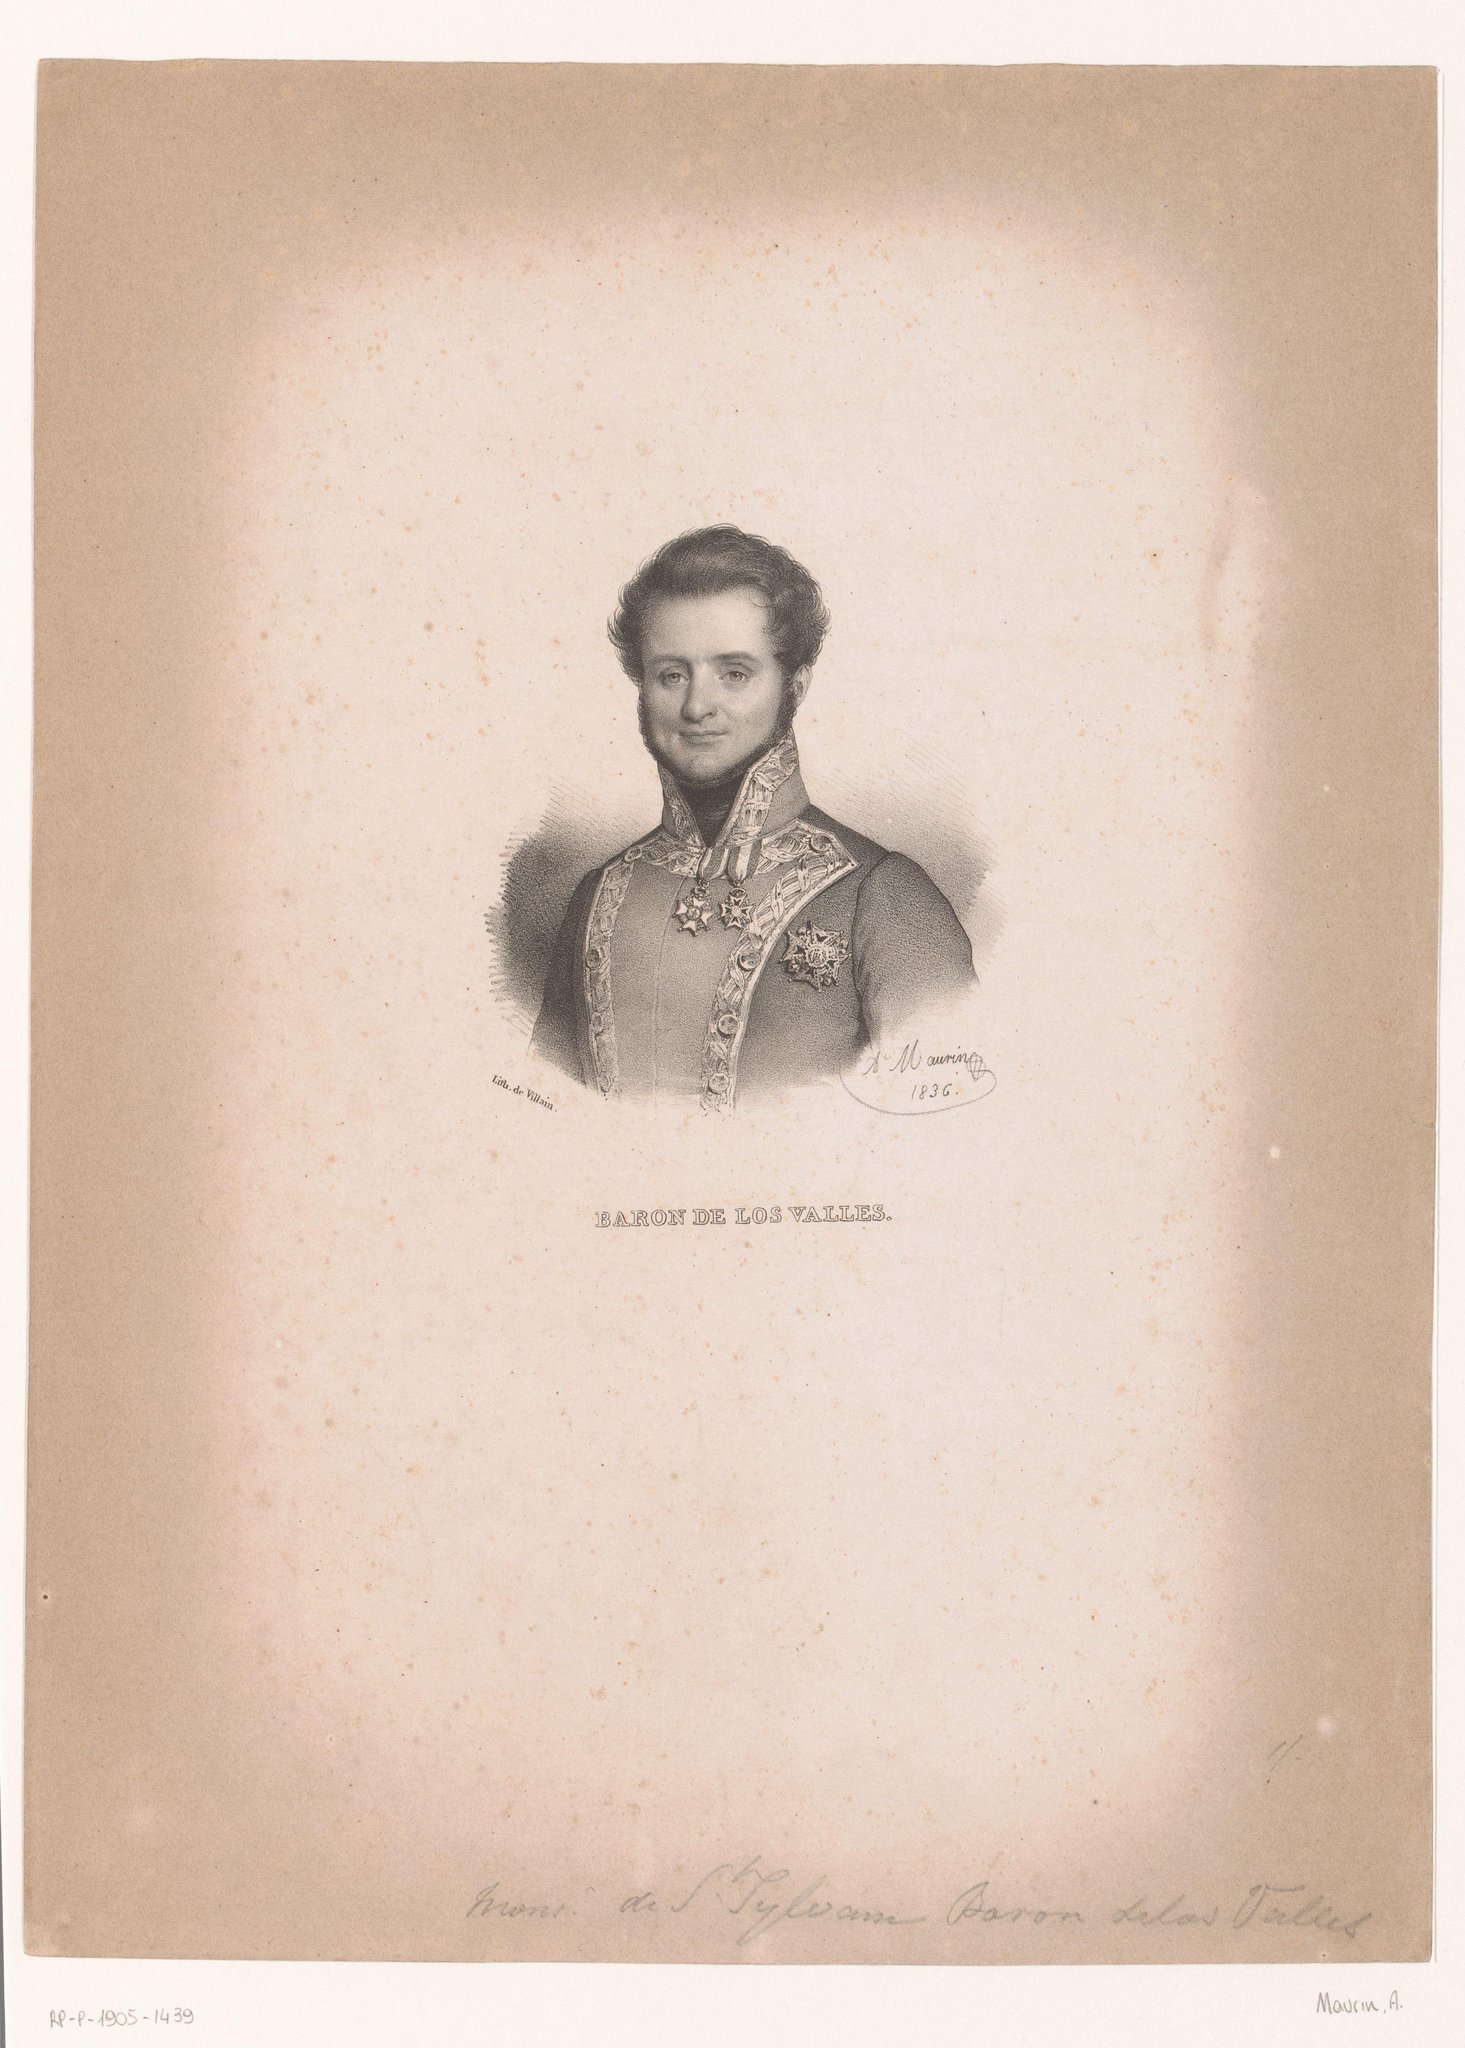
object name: print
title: Portret van Louis Xavier Auguet de Saint-Sylvain, baron van Los Valles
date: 1836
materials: paper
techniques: lithograph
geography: paris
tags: historical persons, the soldier; the soldier's life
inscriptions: collector's mark: Lugt 2228